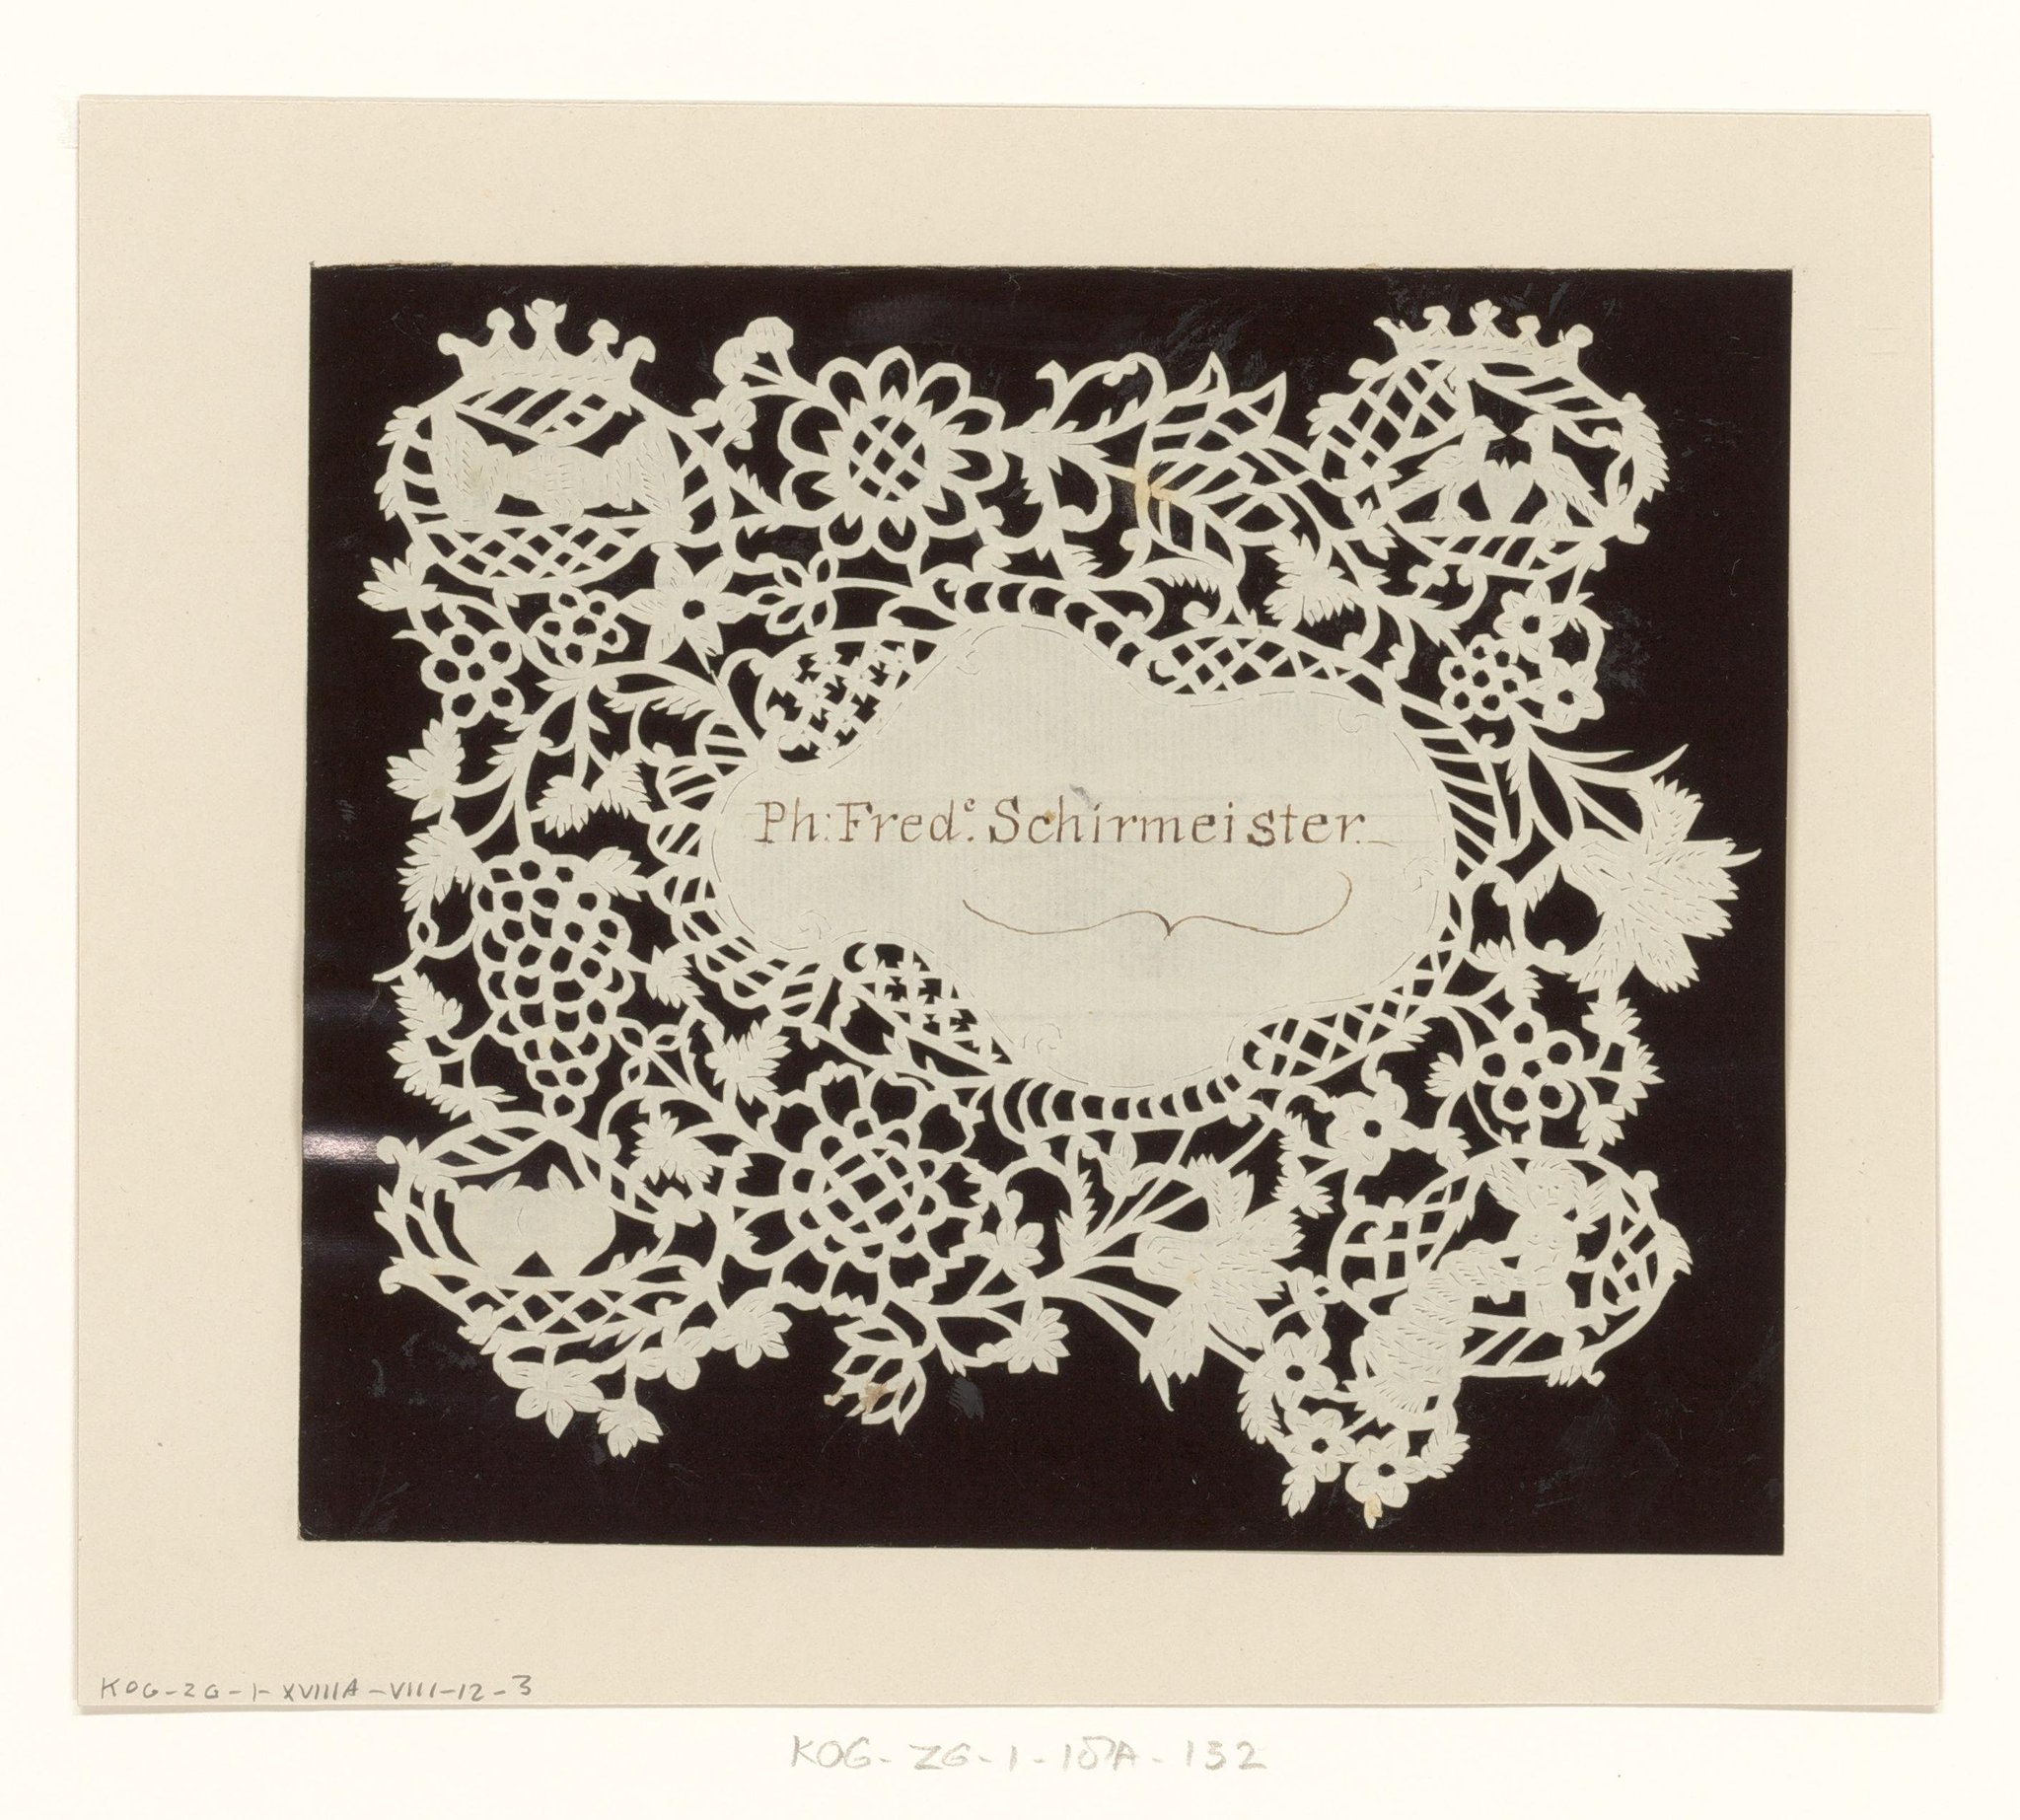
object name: cut paper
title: Huwelijksknipsel voor Ph. Fredc. Schirmeister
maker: Anonymous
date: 1750-1849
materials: ink, paper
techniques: cutting, pen, snipping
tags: flowers, marriage, married couple, 'matrimonium'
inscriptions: stamp, collector's mark: Lugt 1641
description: Plaatsaanduiding voor huwelijksmaaltijd voor Ph. Fredc. Schirmeister. Om zijn naam ranken met bloemen en een druiventros. Linksboven twee in elkaar grijpende handen. Rechtsboven twee duifjes aan weerszijden van een hart. Linksonder twee brandende harten. Rechtsonder een Amor met een hoorn des overvloeds. Onderwerpsrubrieken binnen de Atlas Zeden en Gewoonten: Schoone kunsten, Knipkunst.